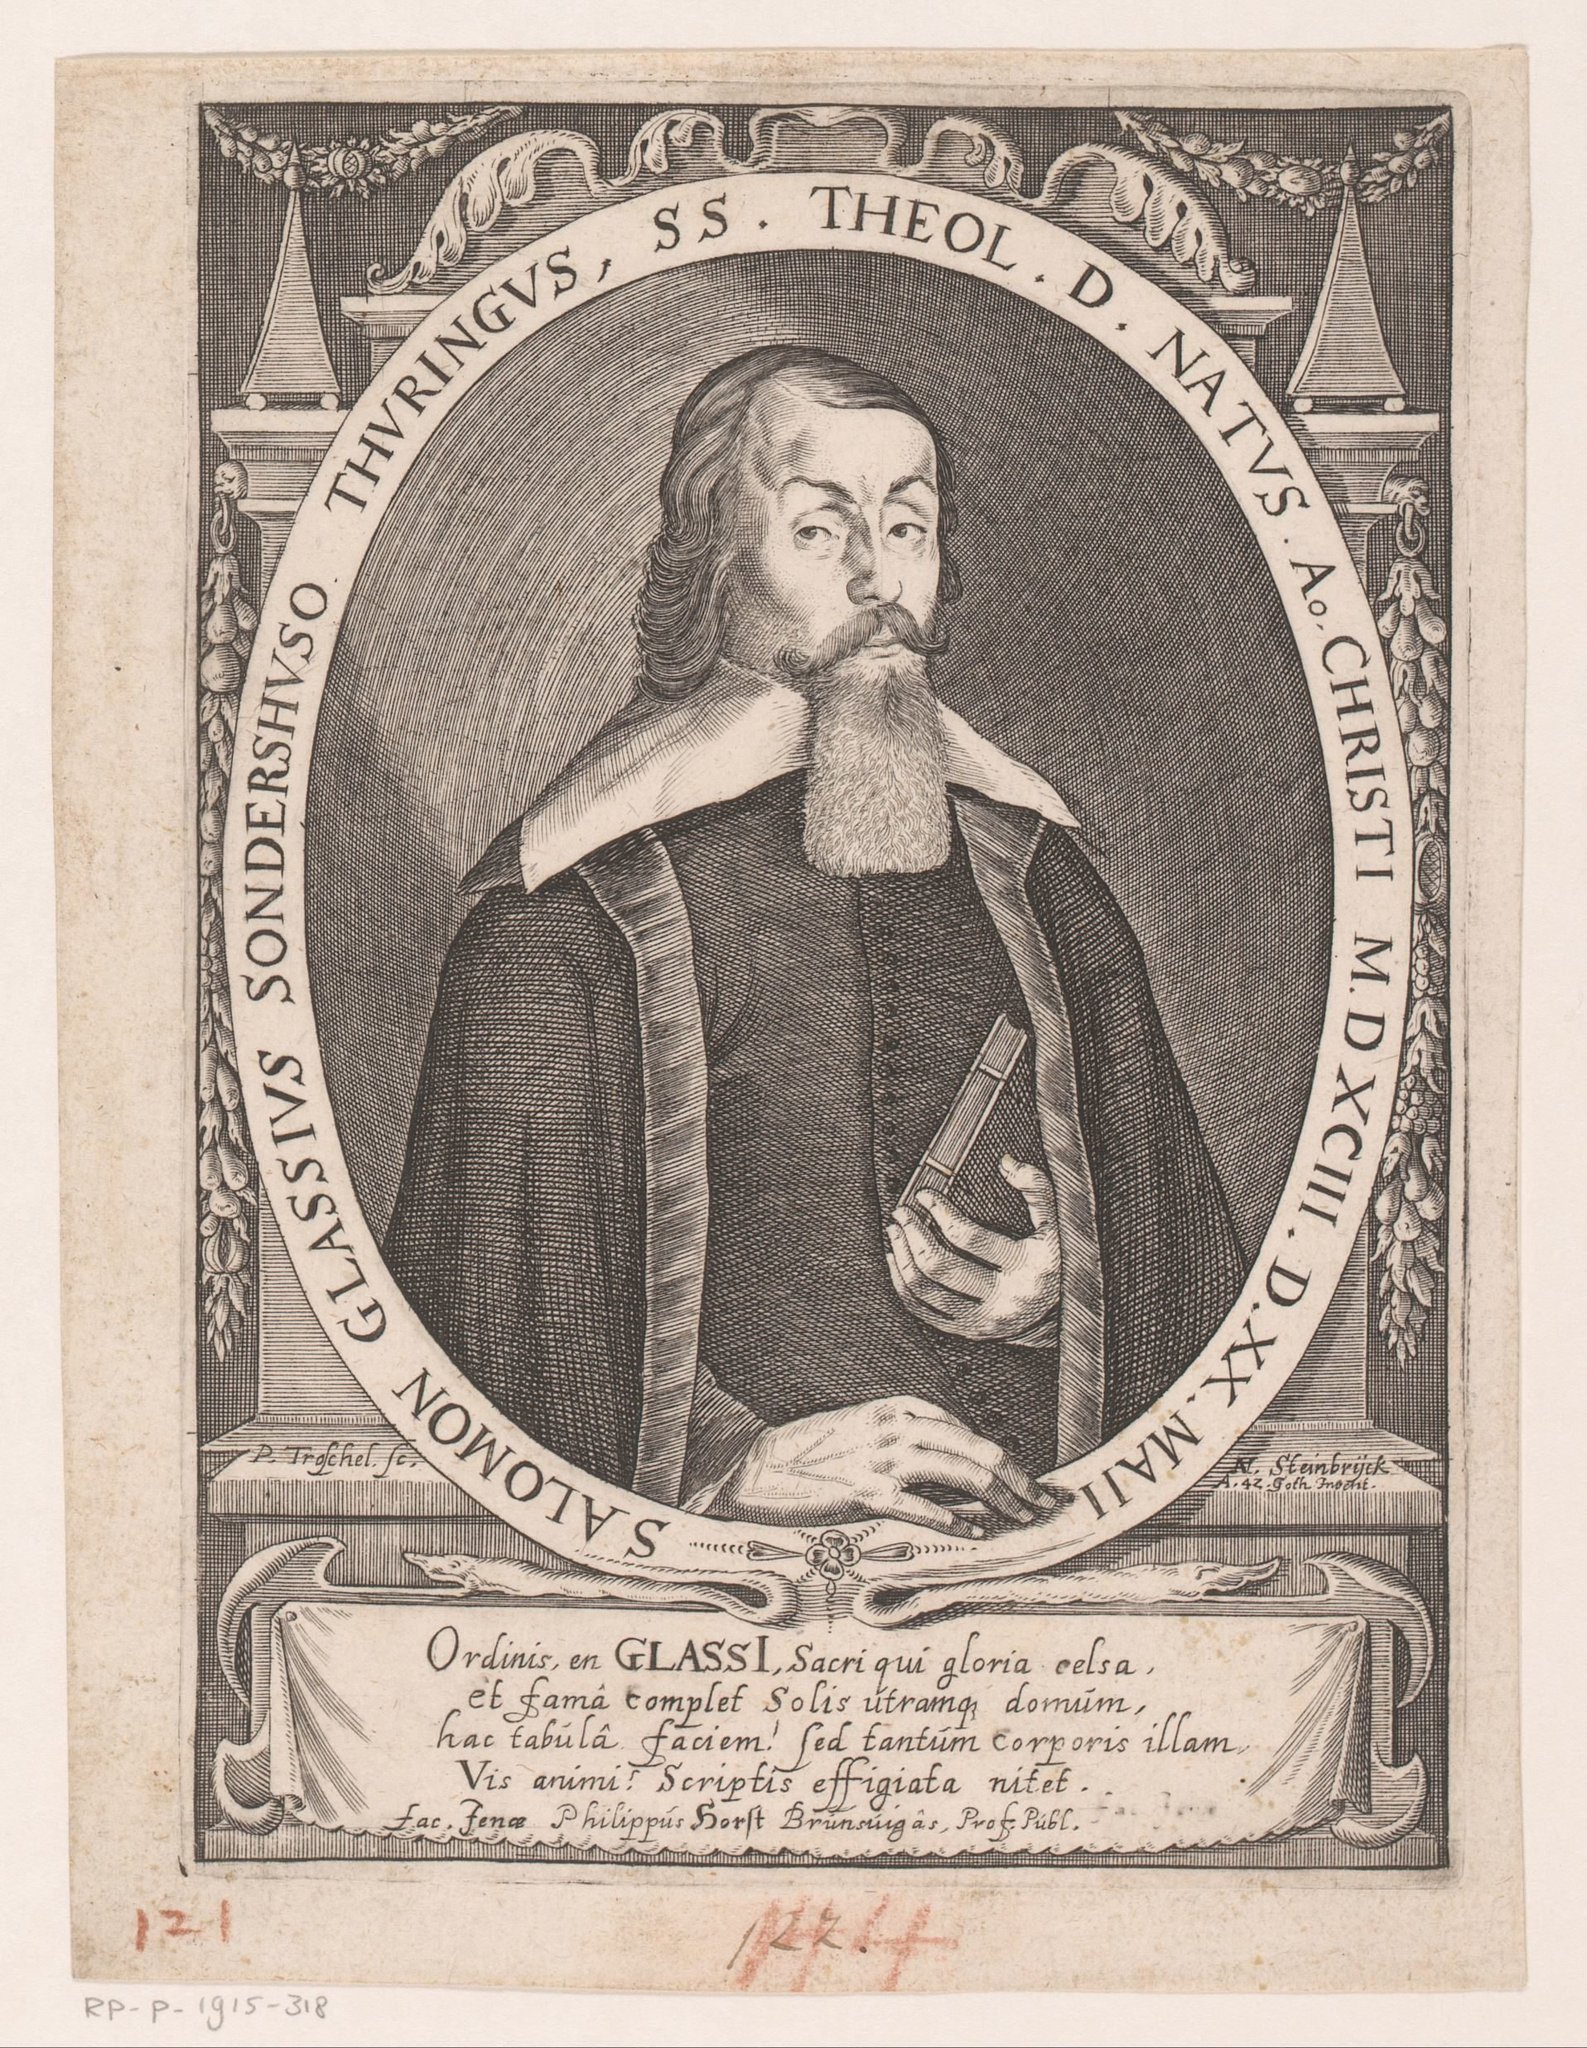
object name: print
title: Portret van Salomon Glass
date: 1642-1670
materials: paper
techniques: engraving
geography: germany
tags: historical persons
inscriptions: collector's mark: Lugt 2228, number: ‘121/ 144’, number: ‘122’